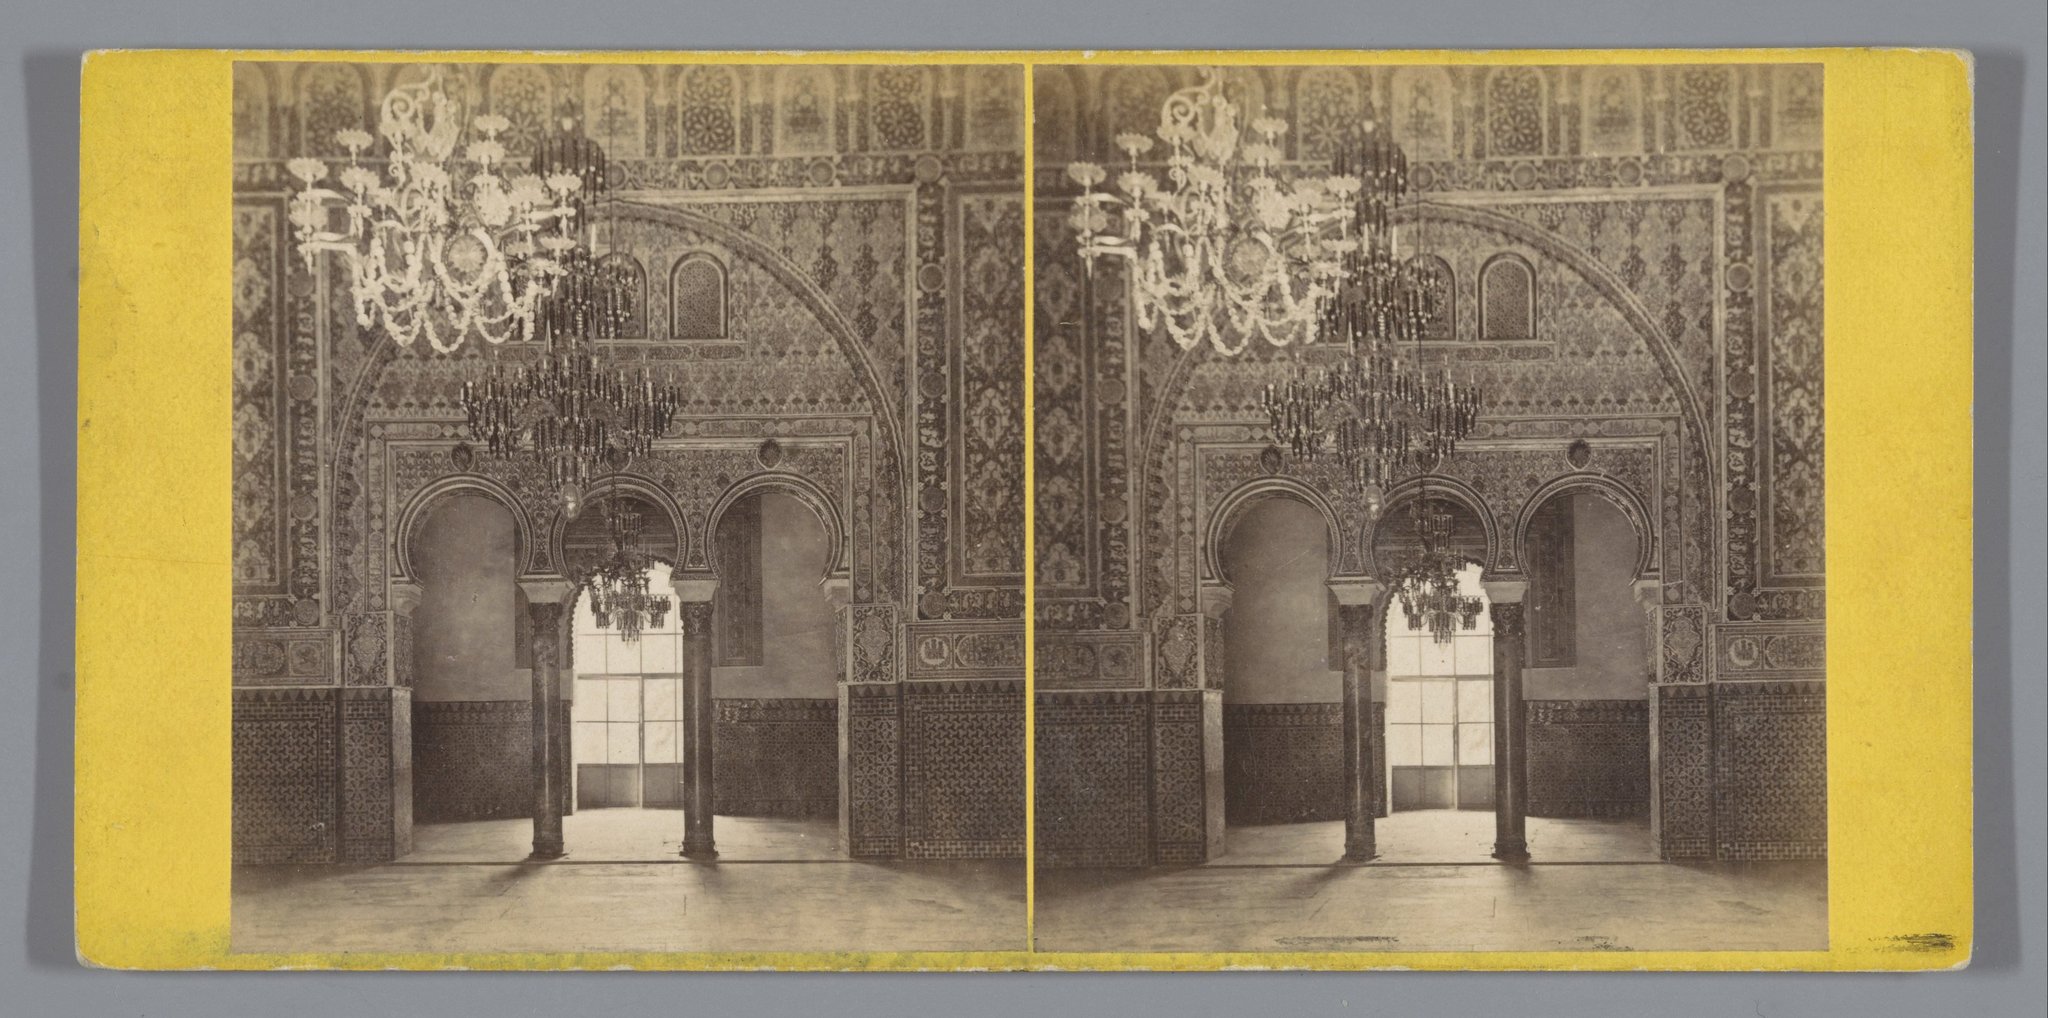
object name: stereograph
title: Interieur van het Koninklijk Paleis van Sevilla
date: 1850-1880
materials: cardboard, photographic support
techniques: albumen print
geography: london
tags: palace, interior ~ representation of a building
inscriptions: name: ‘Frank M. Good's Spain’, number: ‘No. 327.’